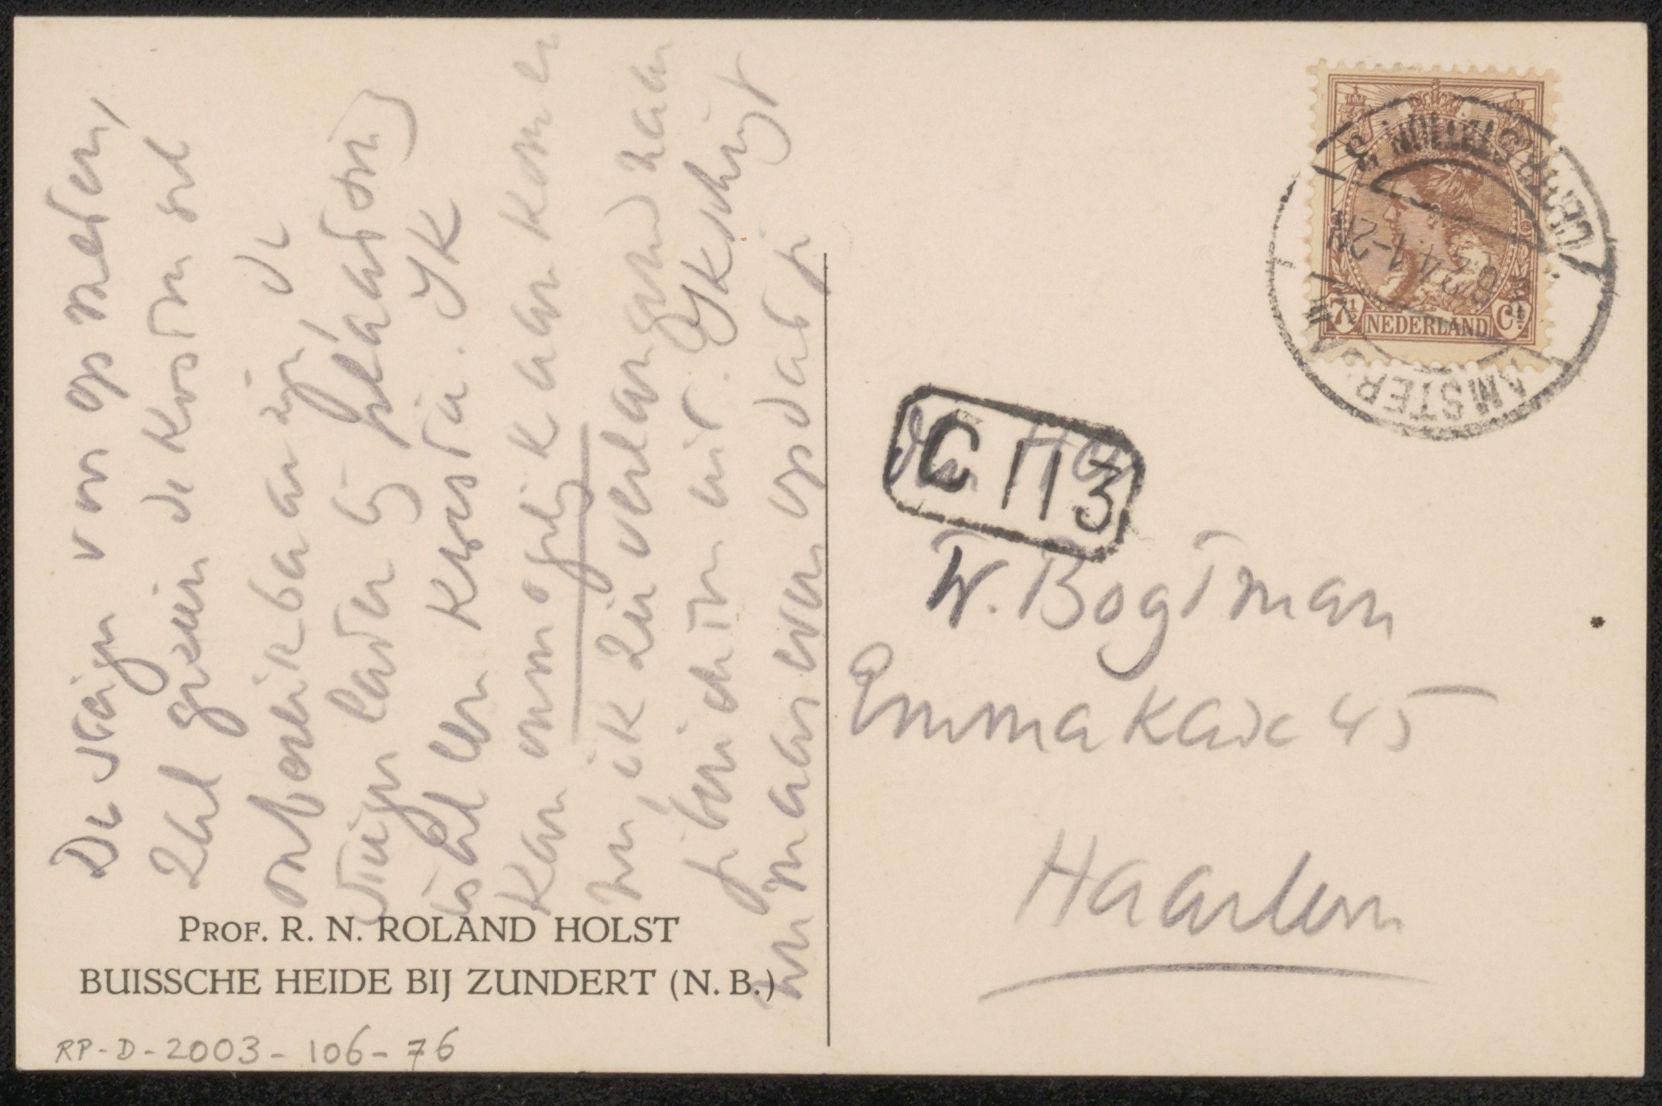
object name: postcard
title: Briefkaart aan Willem Bogtman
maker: richard nicolaüs roland holst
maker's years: 1868-1938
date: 1924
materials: cardboard, pencil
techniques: writing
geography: amsterdam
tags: haarlem, willem bogtman, family life, diseases, money